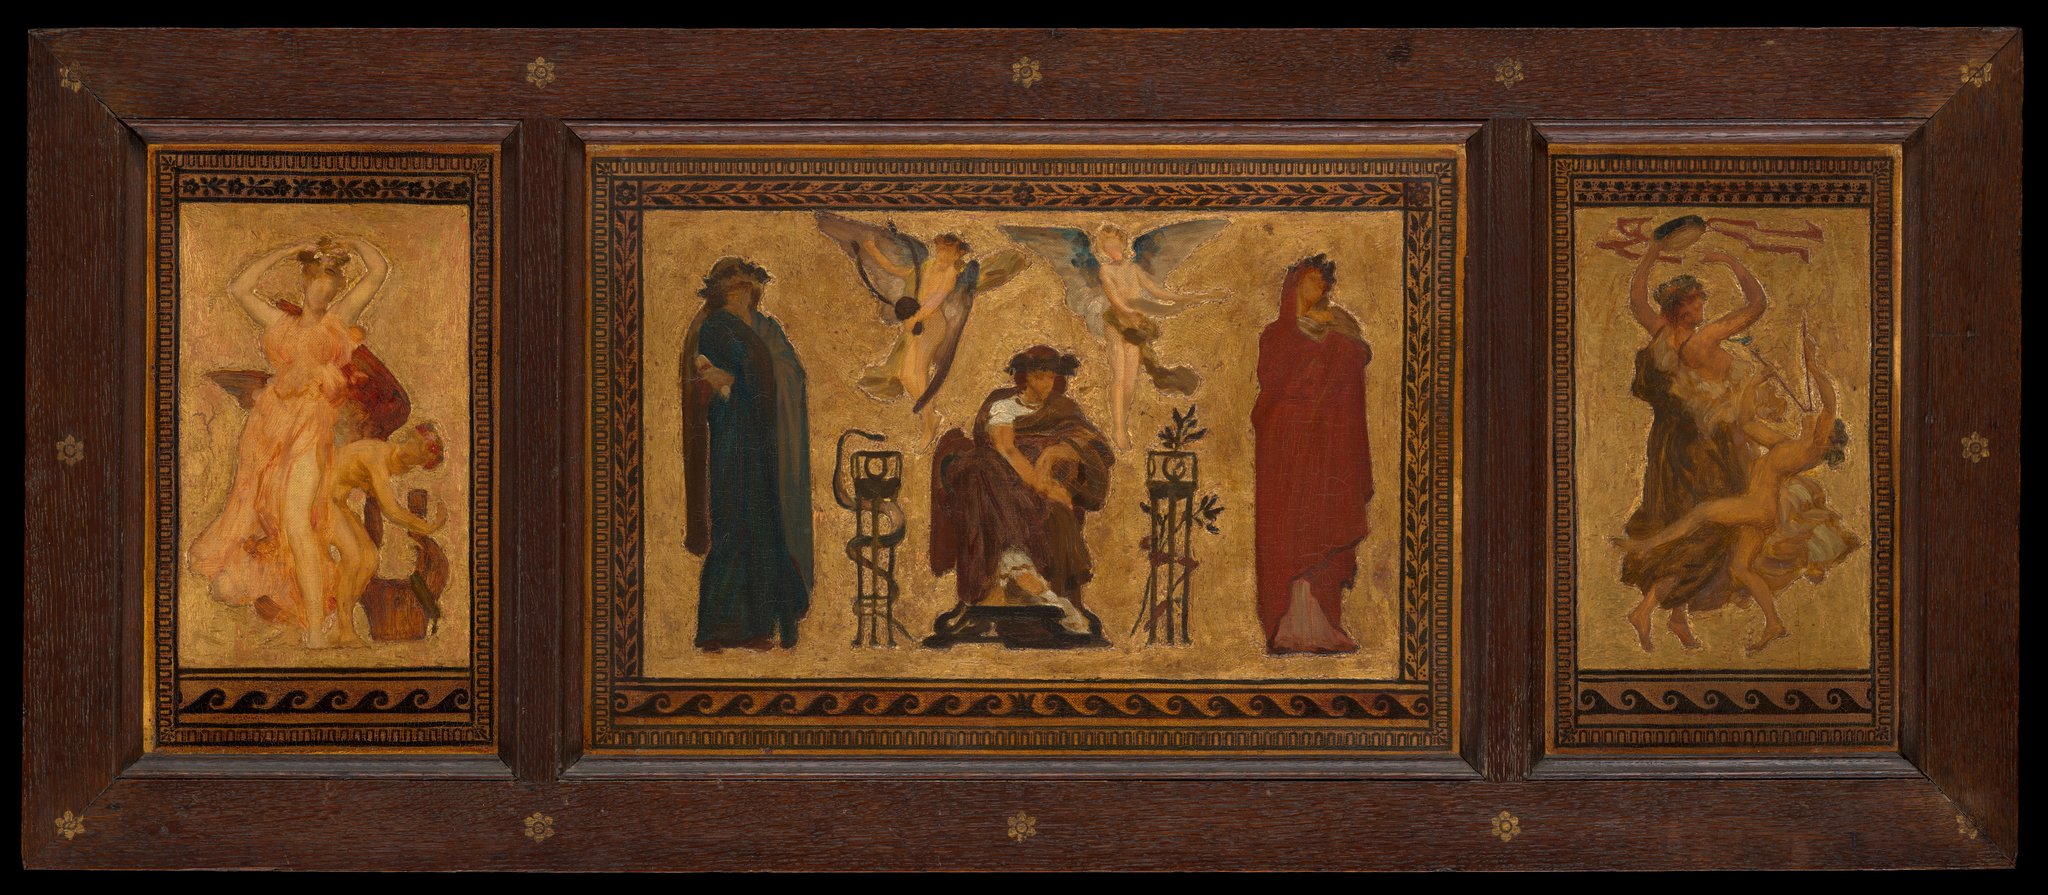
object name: painting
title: Study for the Ceiling of the Marquand Music Room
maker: frederic, lord leighton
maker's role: artist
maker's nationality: british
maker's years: 1830-1896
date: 1886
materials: canvas, gold, oil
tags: muses,goddess,allegory